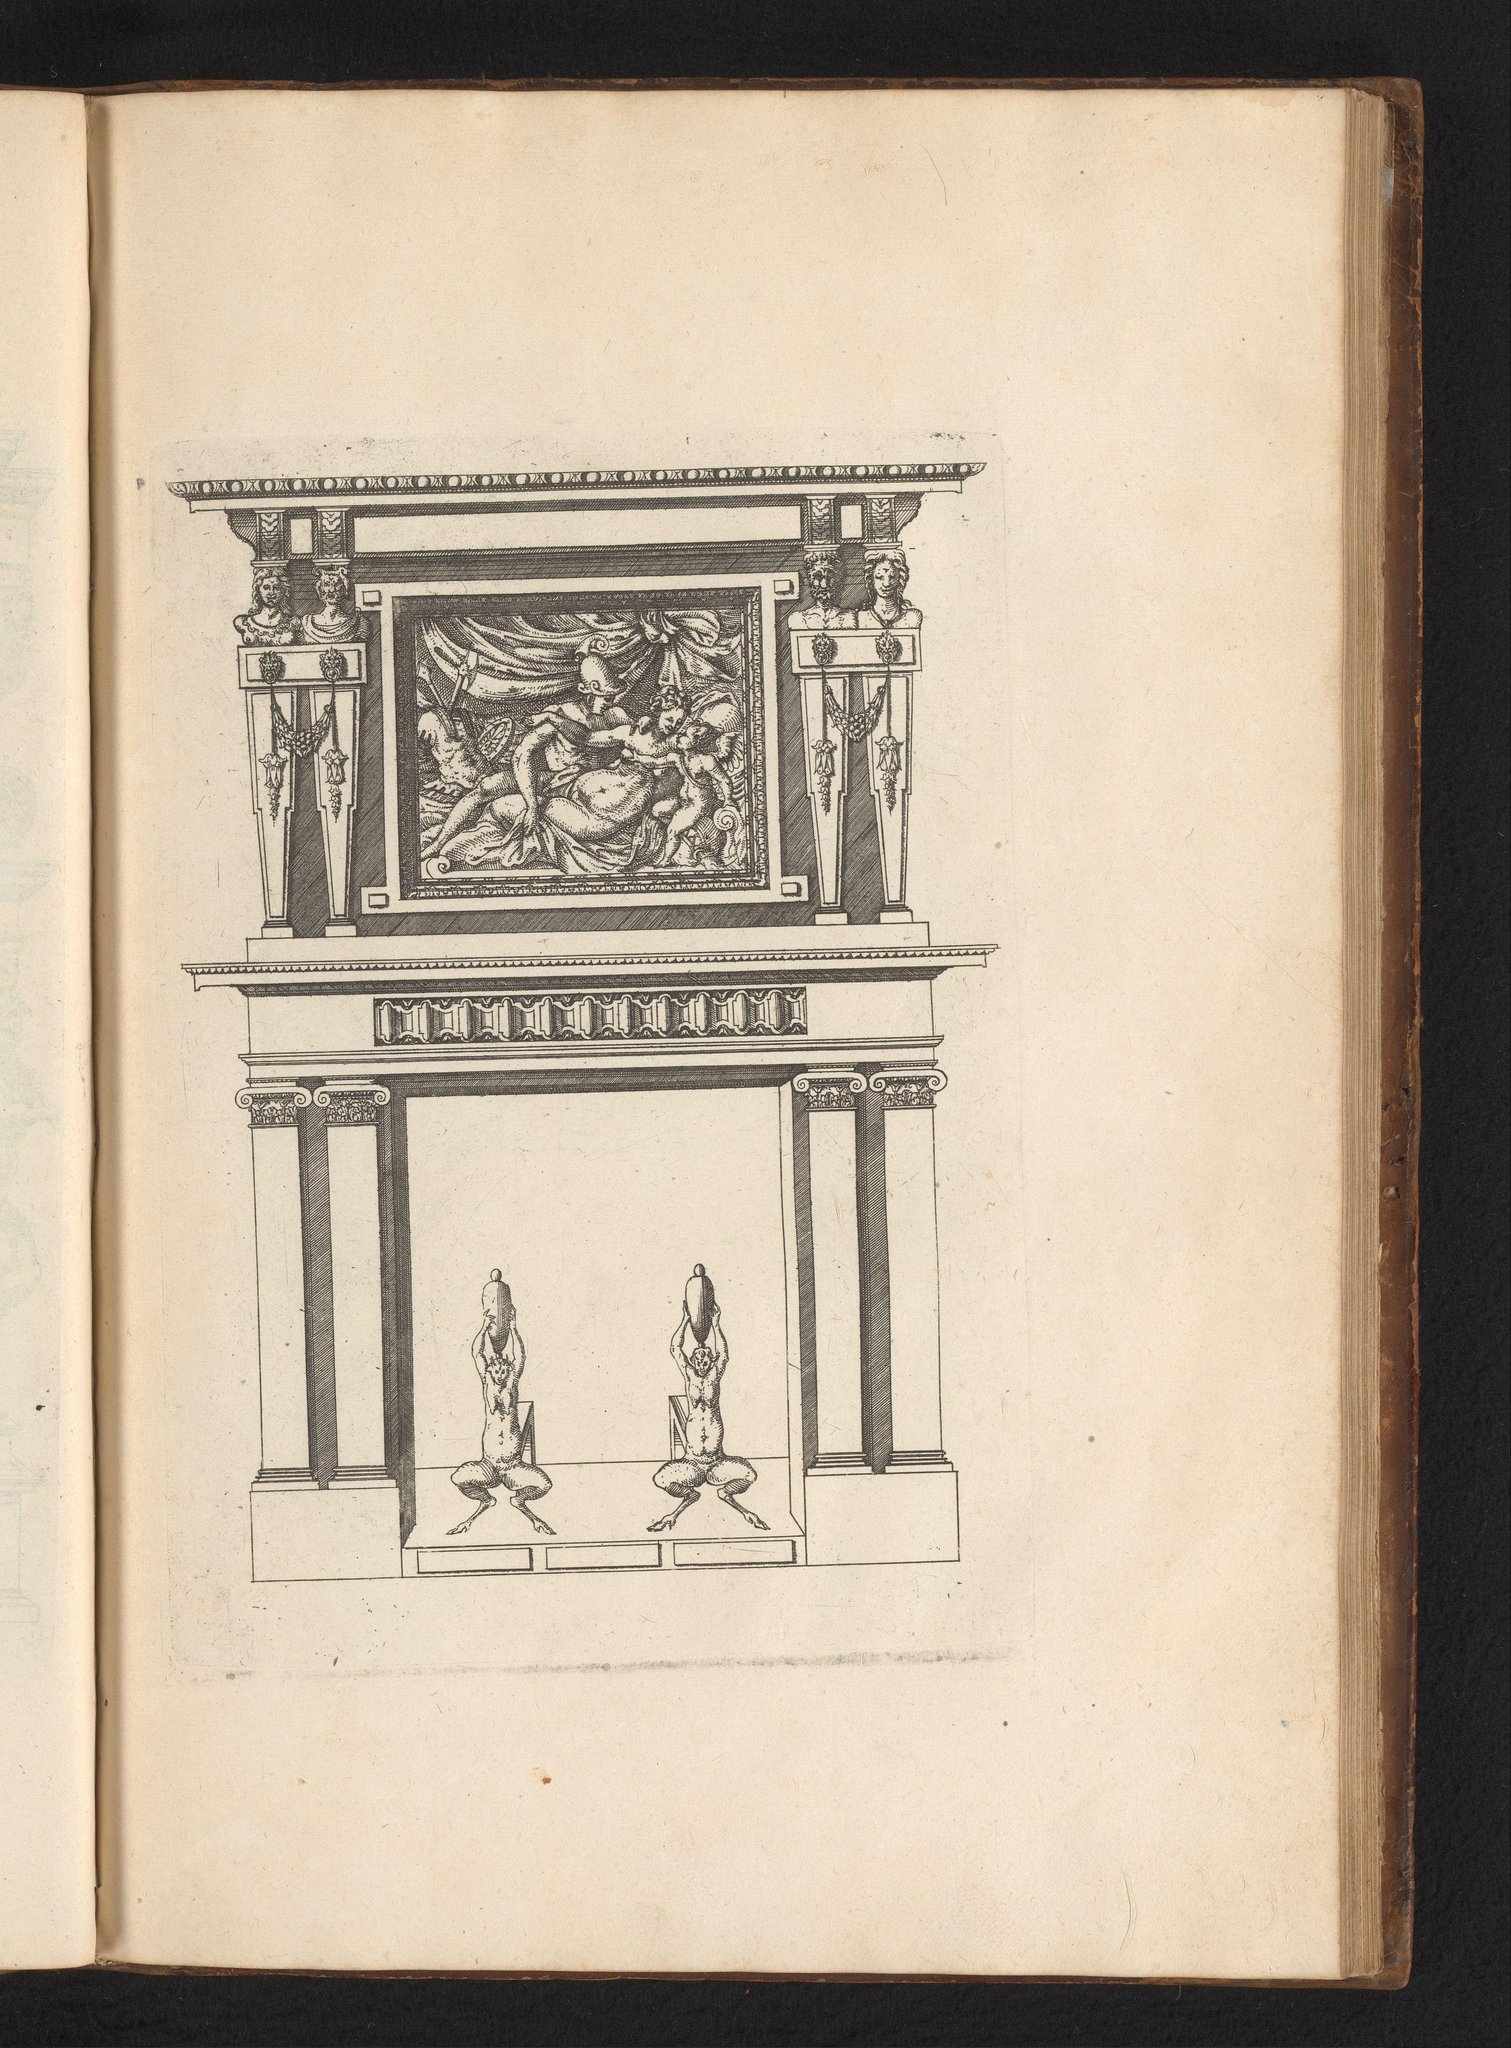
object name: ornament print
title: Schoorsteenmantel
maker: jacques androuet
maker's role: draughtsman, print maker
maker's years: 1515-1584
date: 1561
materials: paper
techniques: etching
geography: paris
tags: mars and venus as lovers, architectural design or model, chimney-piece, mantelpiece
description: Schoorsteenmantel met op de schouw een voorstelling van een liefdesscène van Venus en Mars, met Cupido. Onderdeel van 'Seconde livre d'architectvre' (1561): 64 etsen met geornamenteerde architectuuronderdelen.